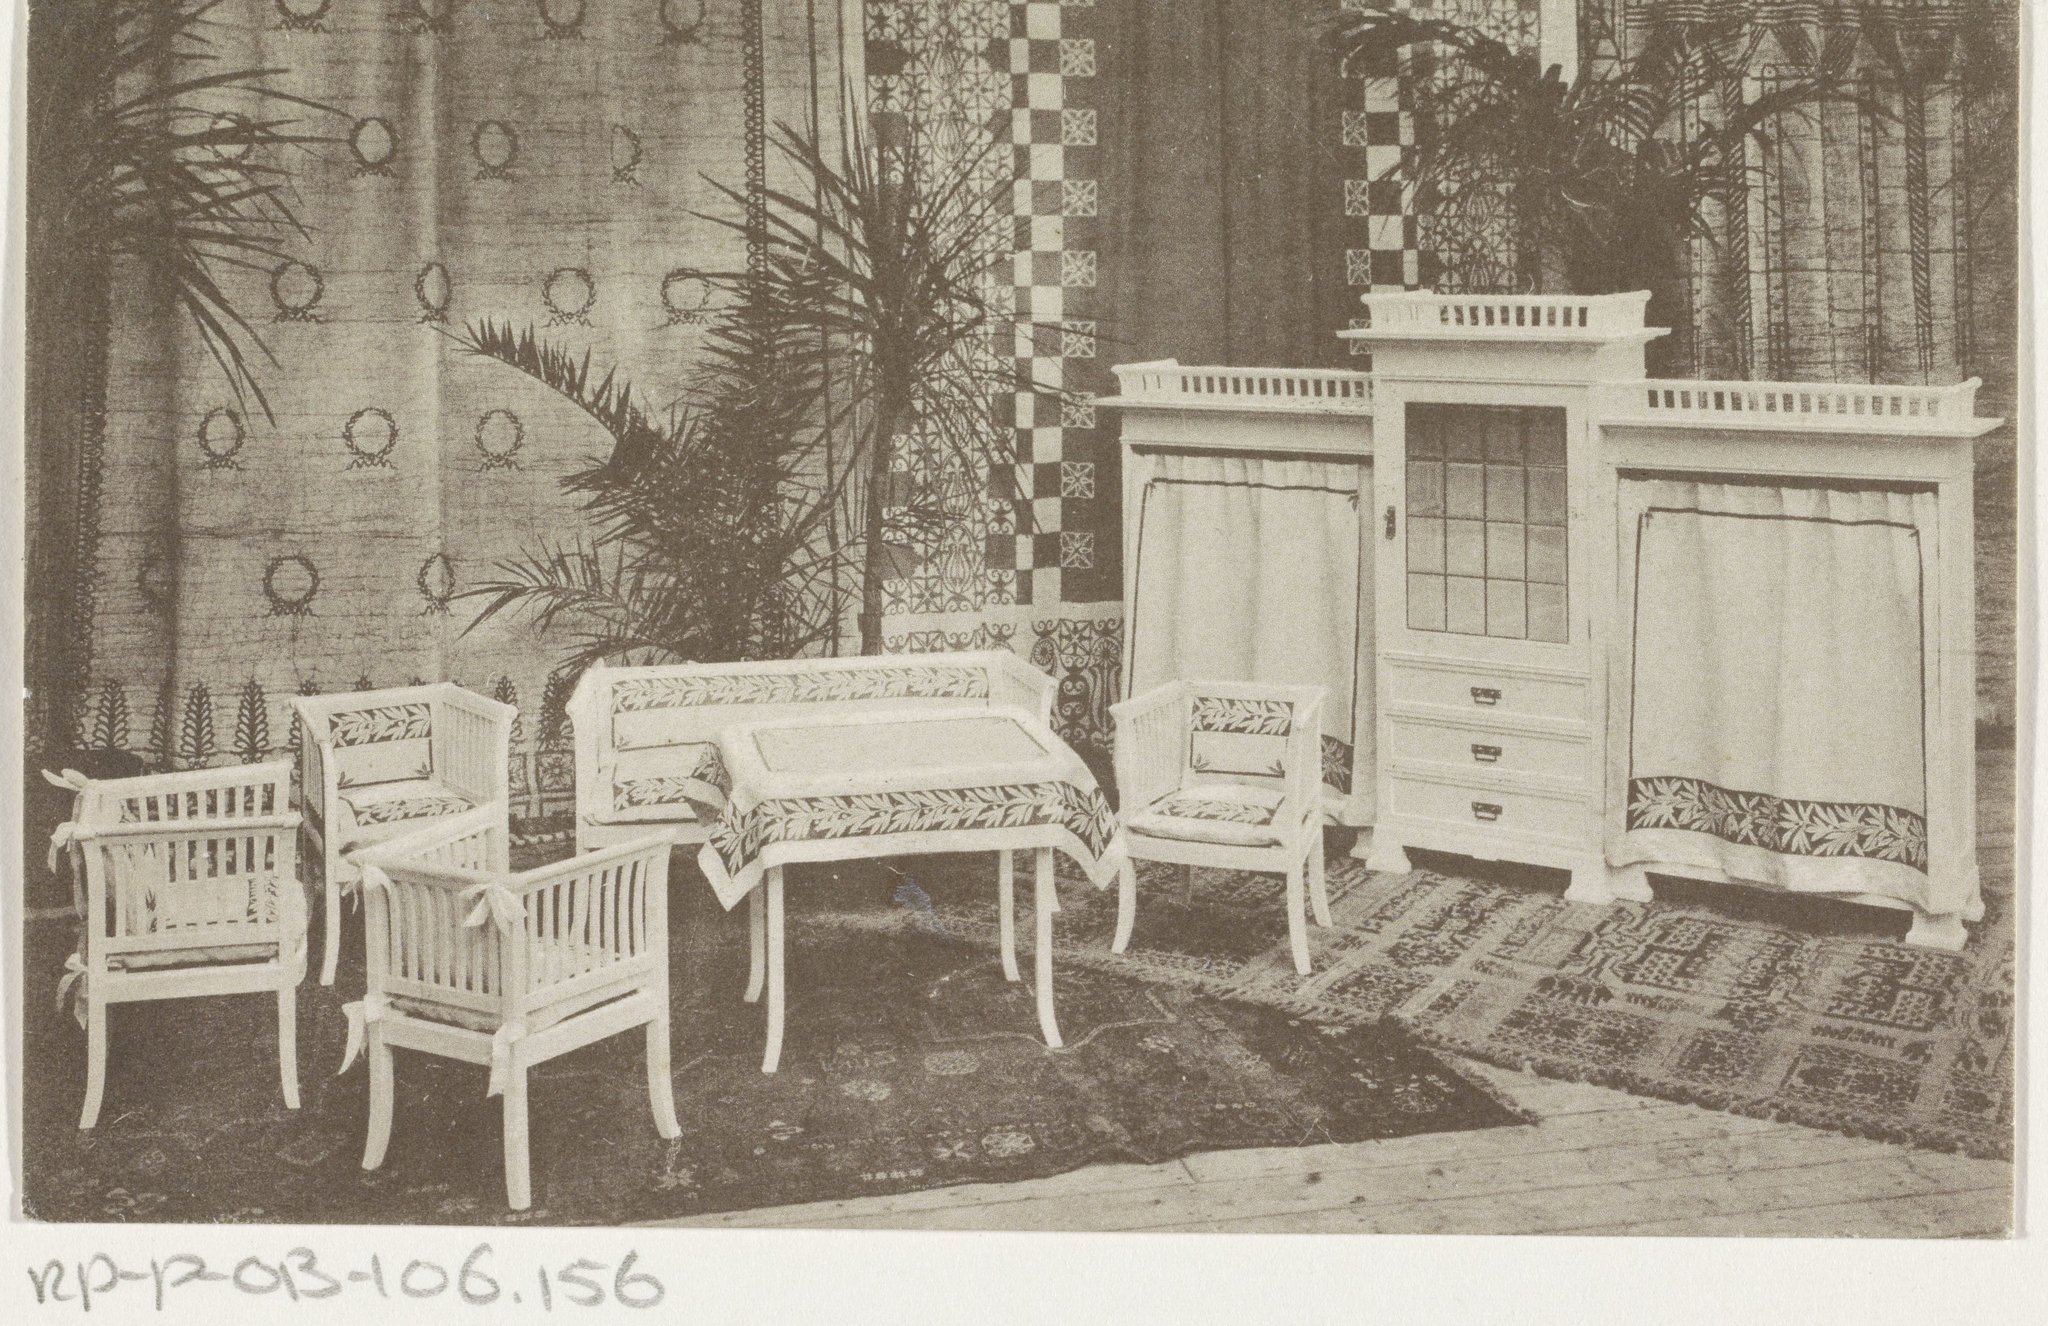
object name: photomechanical print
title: Kindermeubels geschonken aan Wilhelmina, koningin der Nederlanden, door de Apeldoornse vrouwen ter gelegenheid van de geboorte van Juliana, koningin der Nederlanden, op 30 april 1909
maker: Anonymous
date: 1909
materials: paper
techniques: photograph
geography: middelburg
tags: print maker, wilhelmina of the netherlands, juliana of the netherlands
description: De hier vermelde titel verwijst naar de hoogst verkregen titel van de geportretteerde, niet per se naar de titel die de geportretteerde op deze voorstelling draagt.